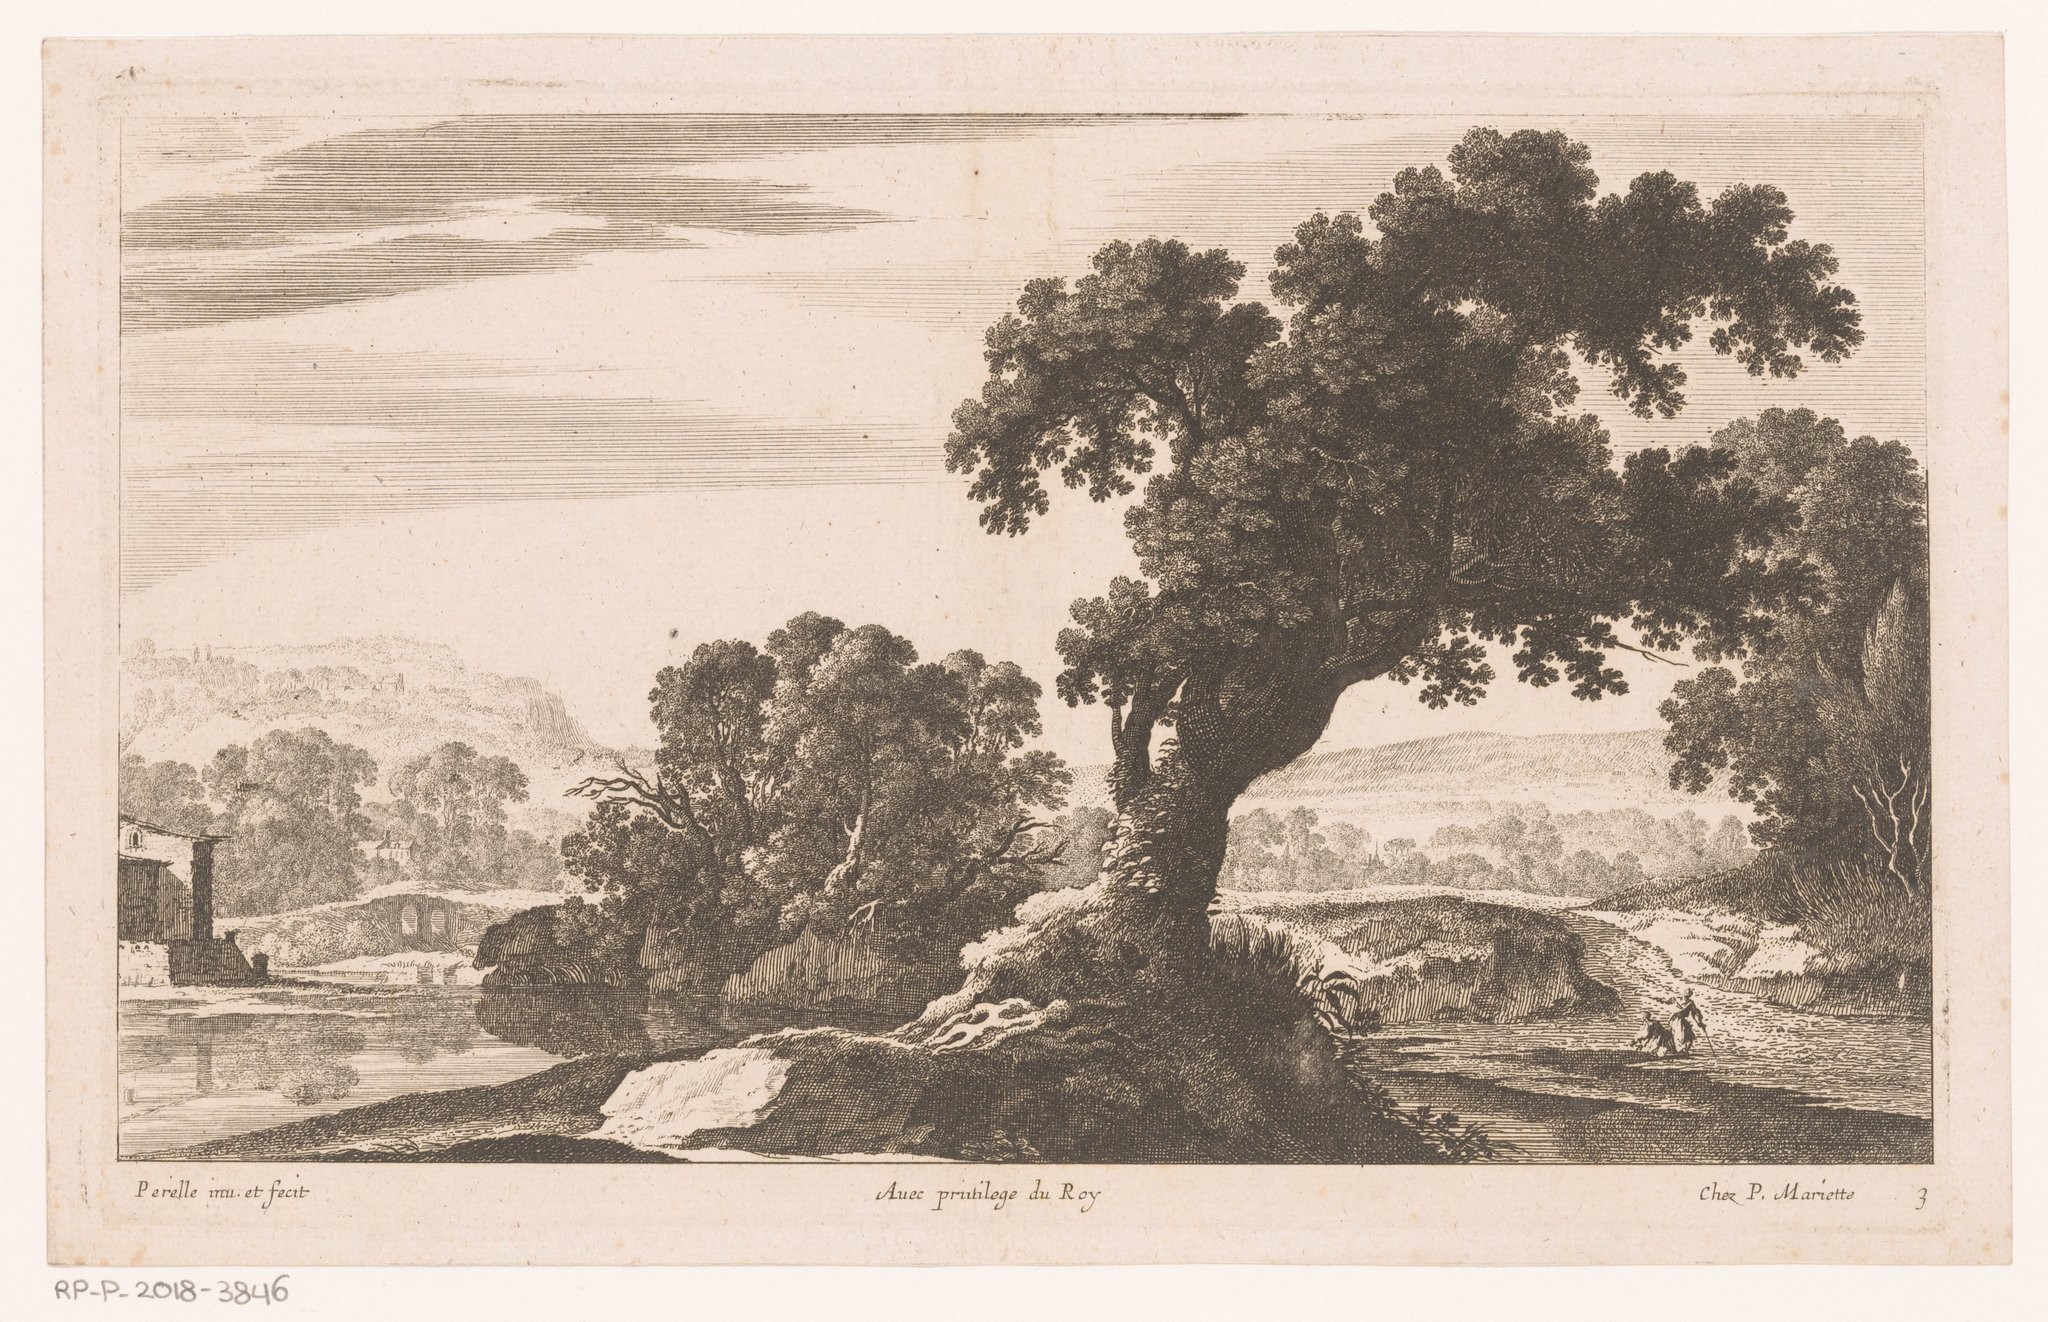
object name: print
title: Landschap met boom bij meer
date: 1613-1695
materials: paper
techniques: engraving, etching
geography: france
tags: landscapes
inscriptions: collector's mark: Lugt 2166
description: Prenten met het signatuur 'Perelle' kunnen zowel door vader Gabriel als door zonen Nicolas en Adam gemaakt zijn.